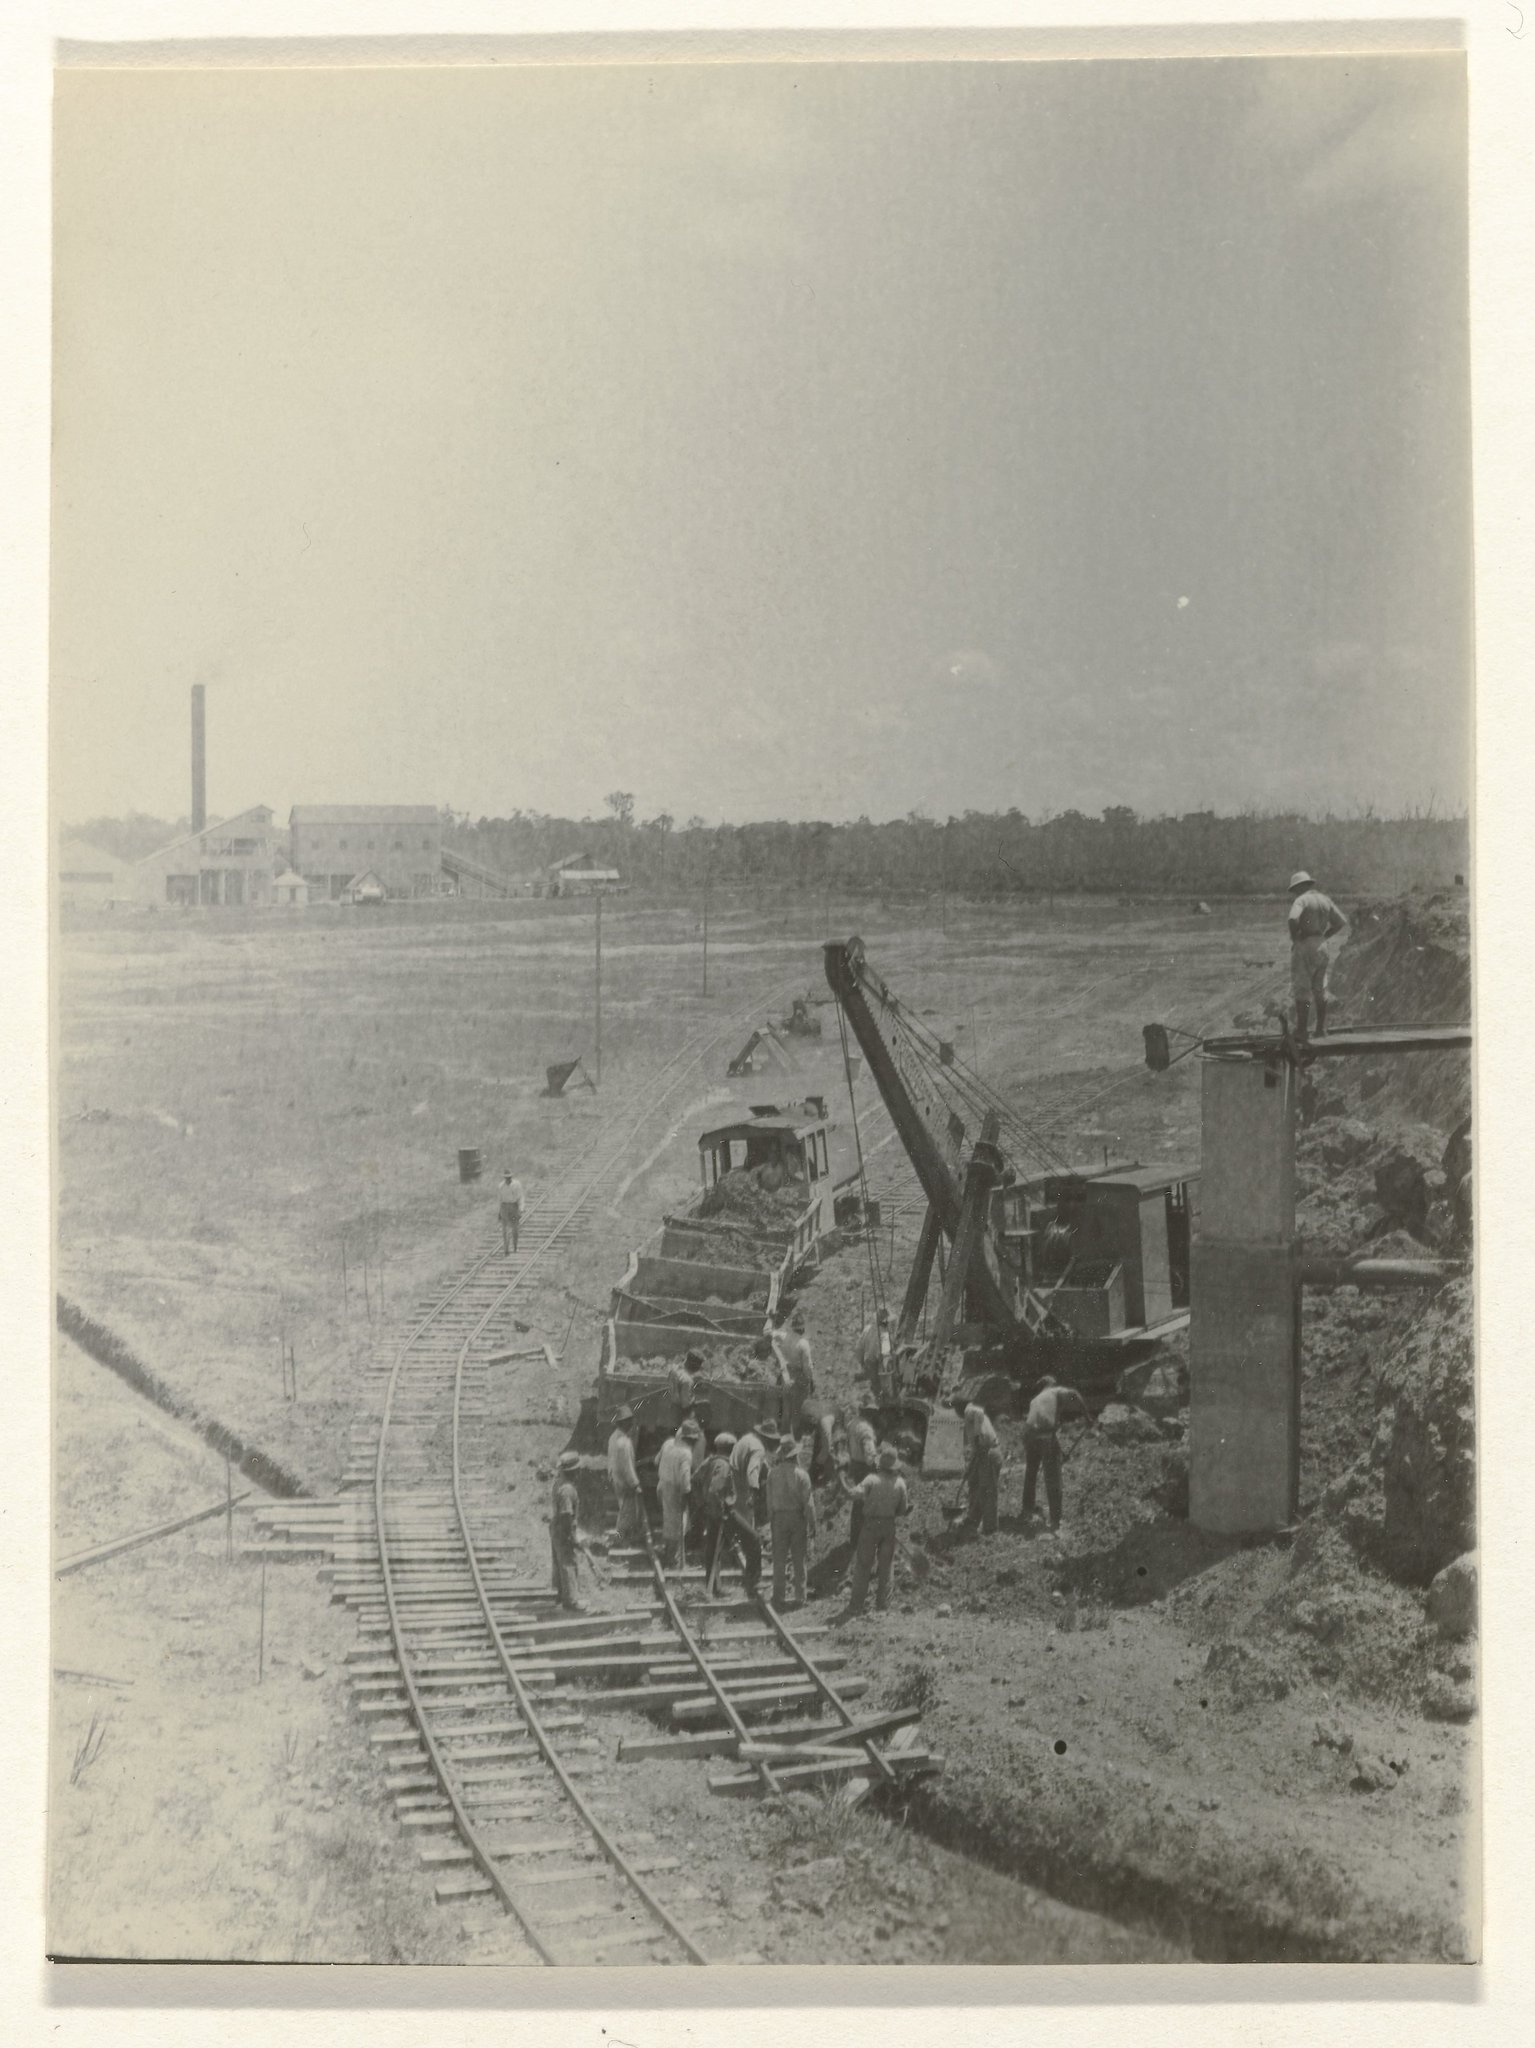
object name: photograph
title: Spoorlijn voor het vervoeren van bauxiet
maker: Anonymous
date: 1929-1930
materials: photographic support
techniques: photography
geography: suriname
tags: opencast mine; strip mining